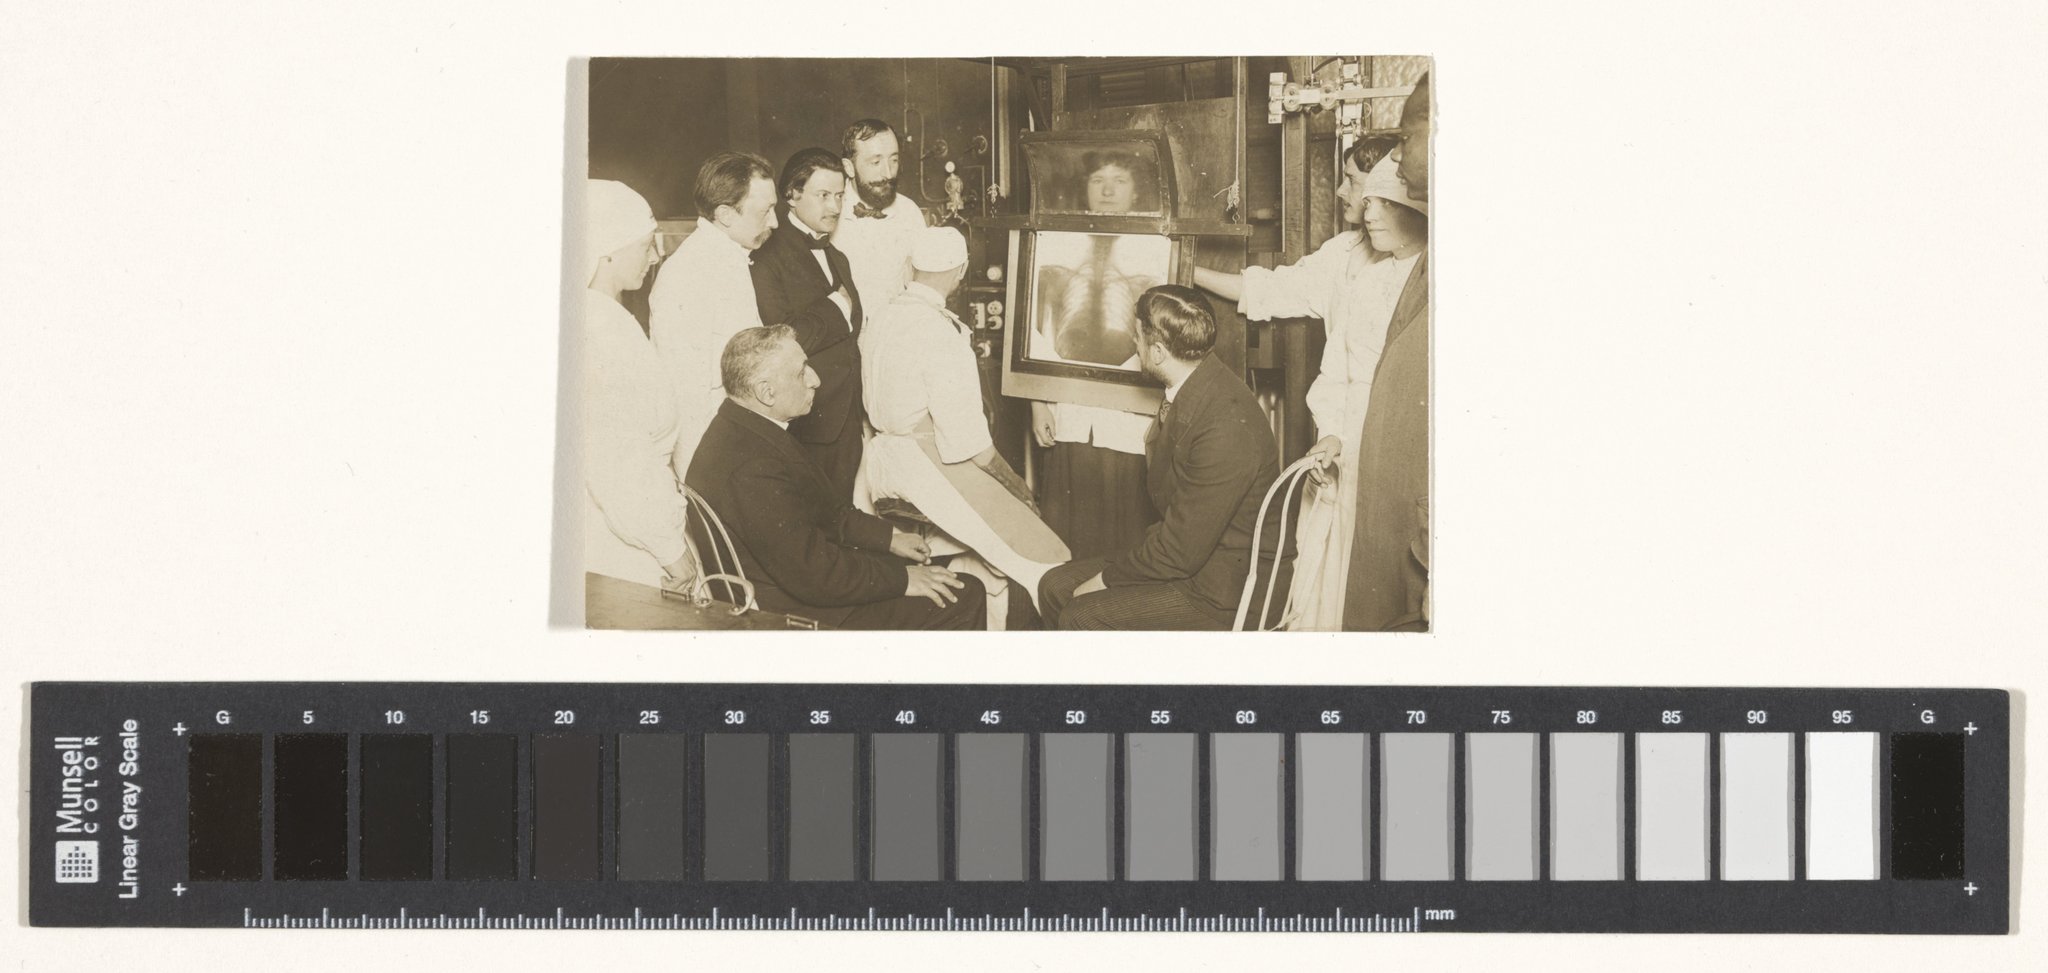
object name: photograph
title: Demonstratie van het maken van een röntgenfoto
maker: Anonymous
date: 1910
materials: paper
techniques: gelatin silver print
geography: europe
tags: x-ray examination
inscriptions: number: ‘No 9760’